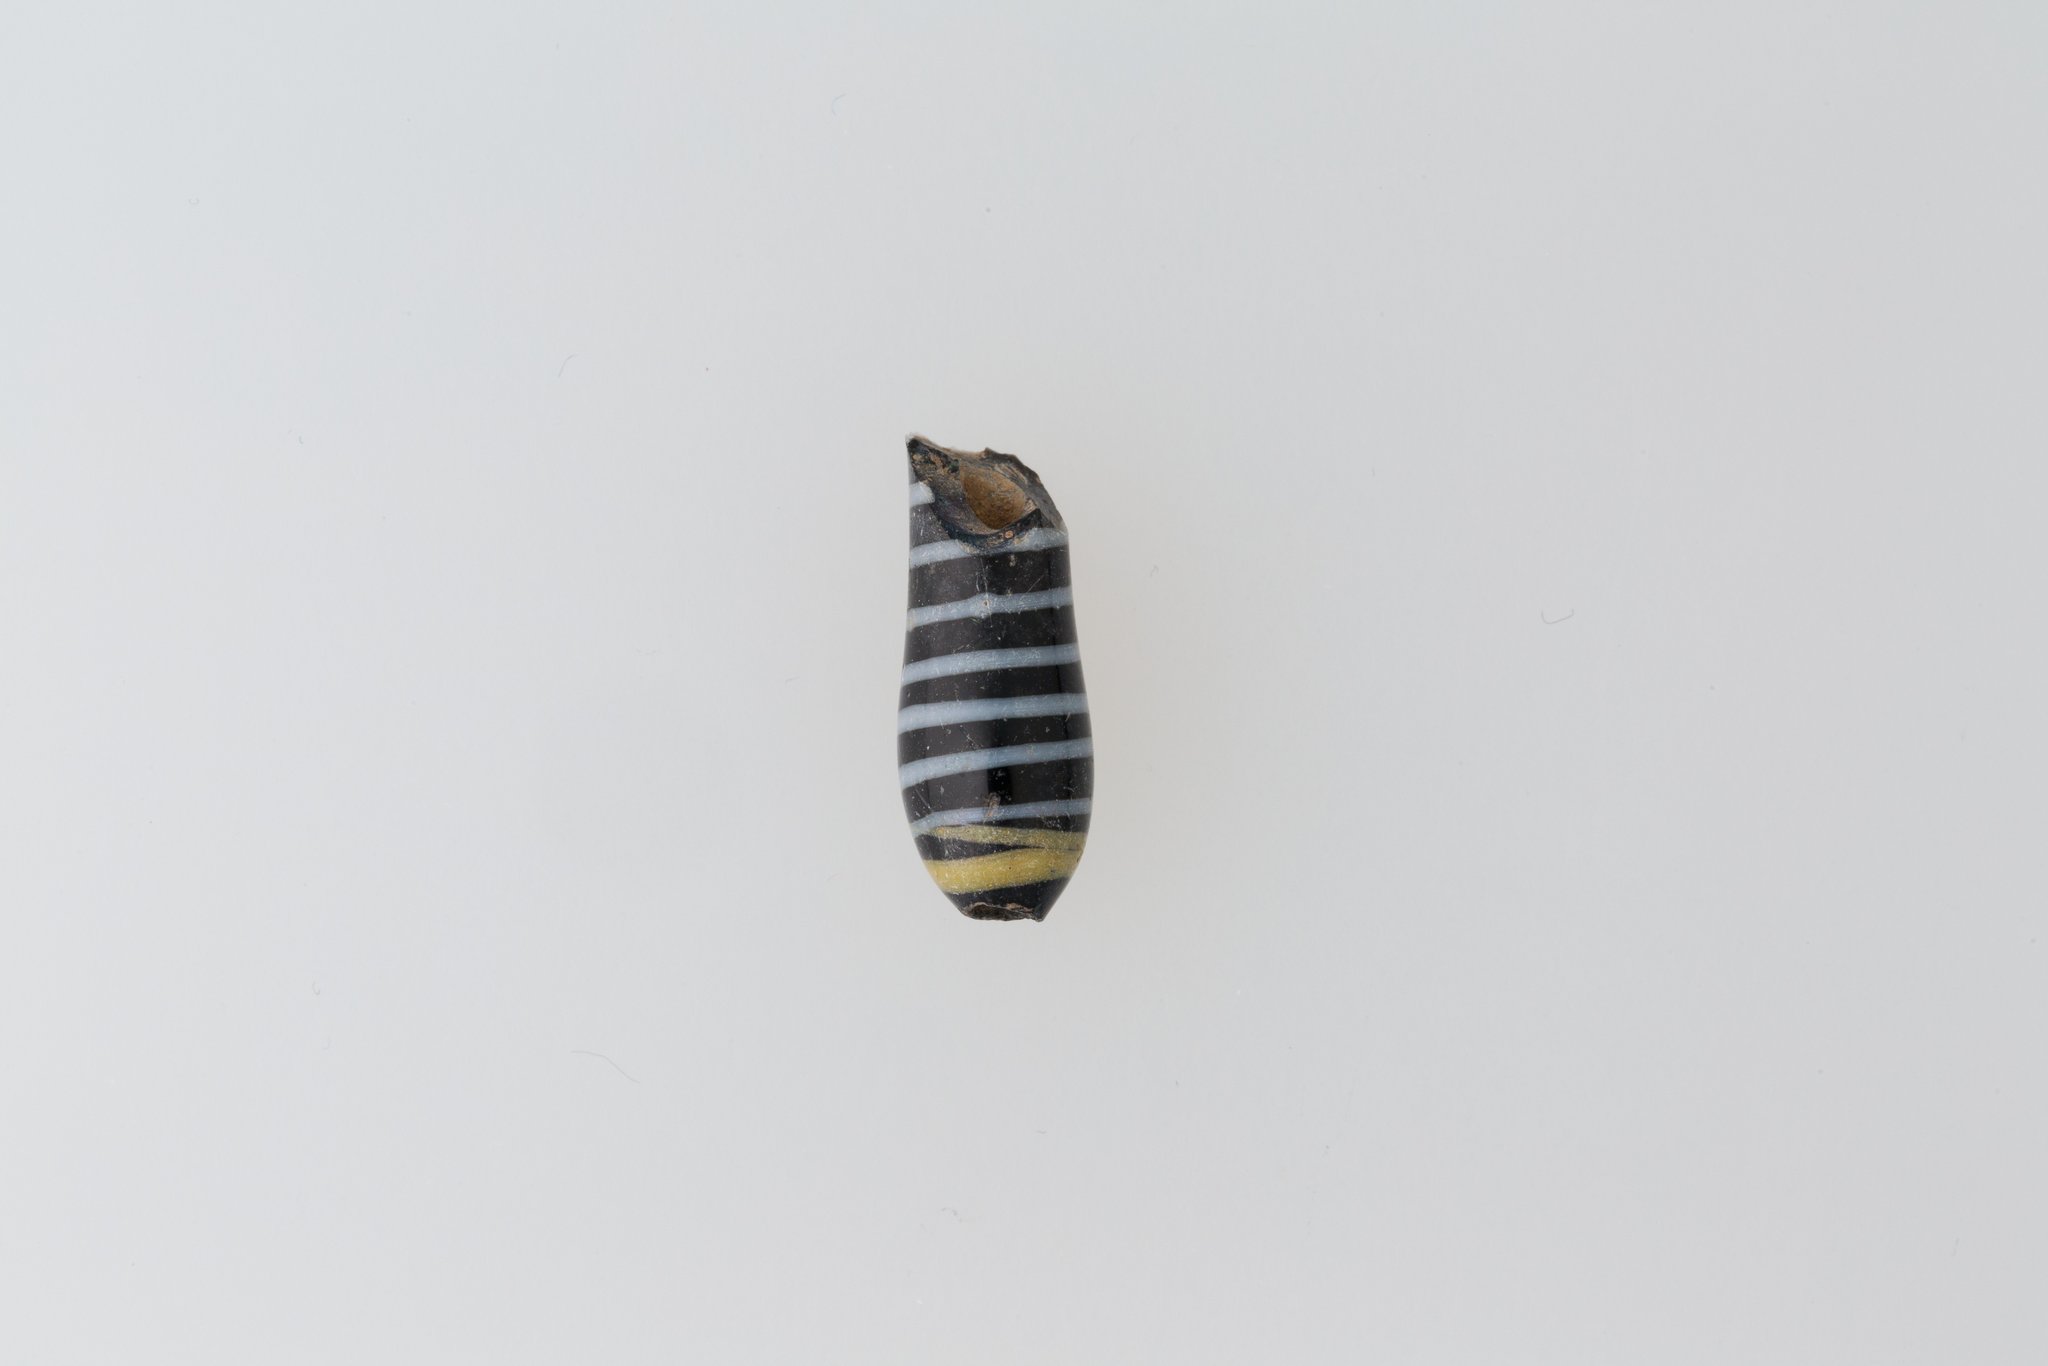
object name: part of an ear stud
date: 1390-1352 BCE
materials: glass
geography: egypt